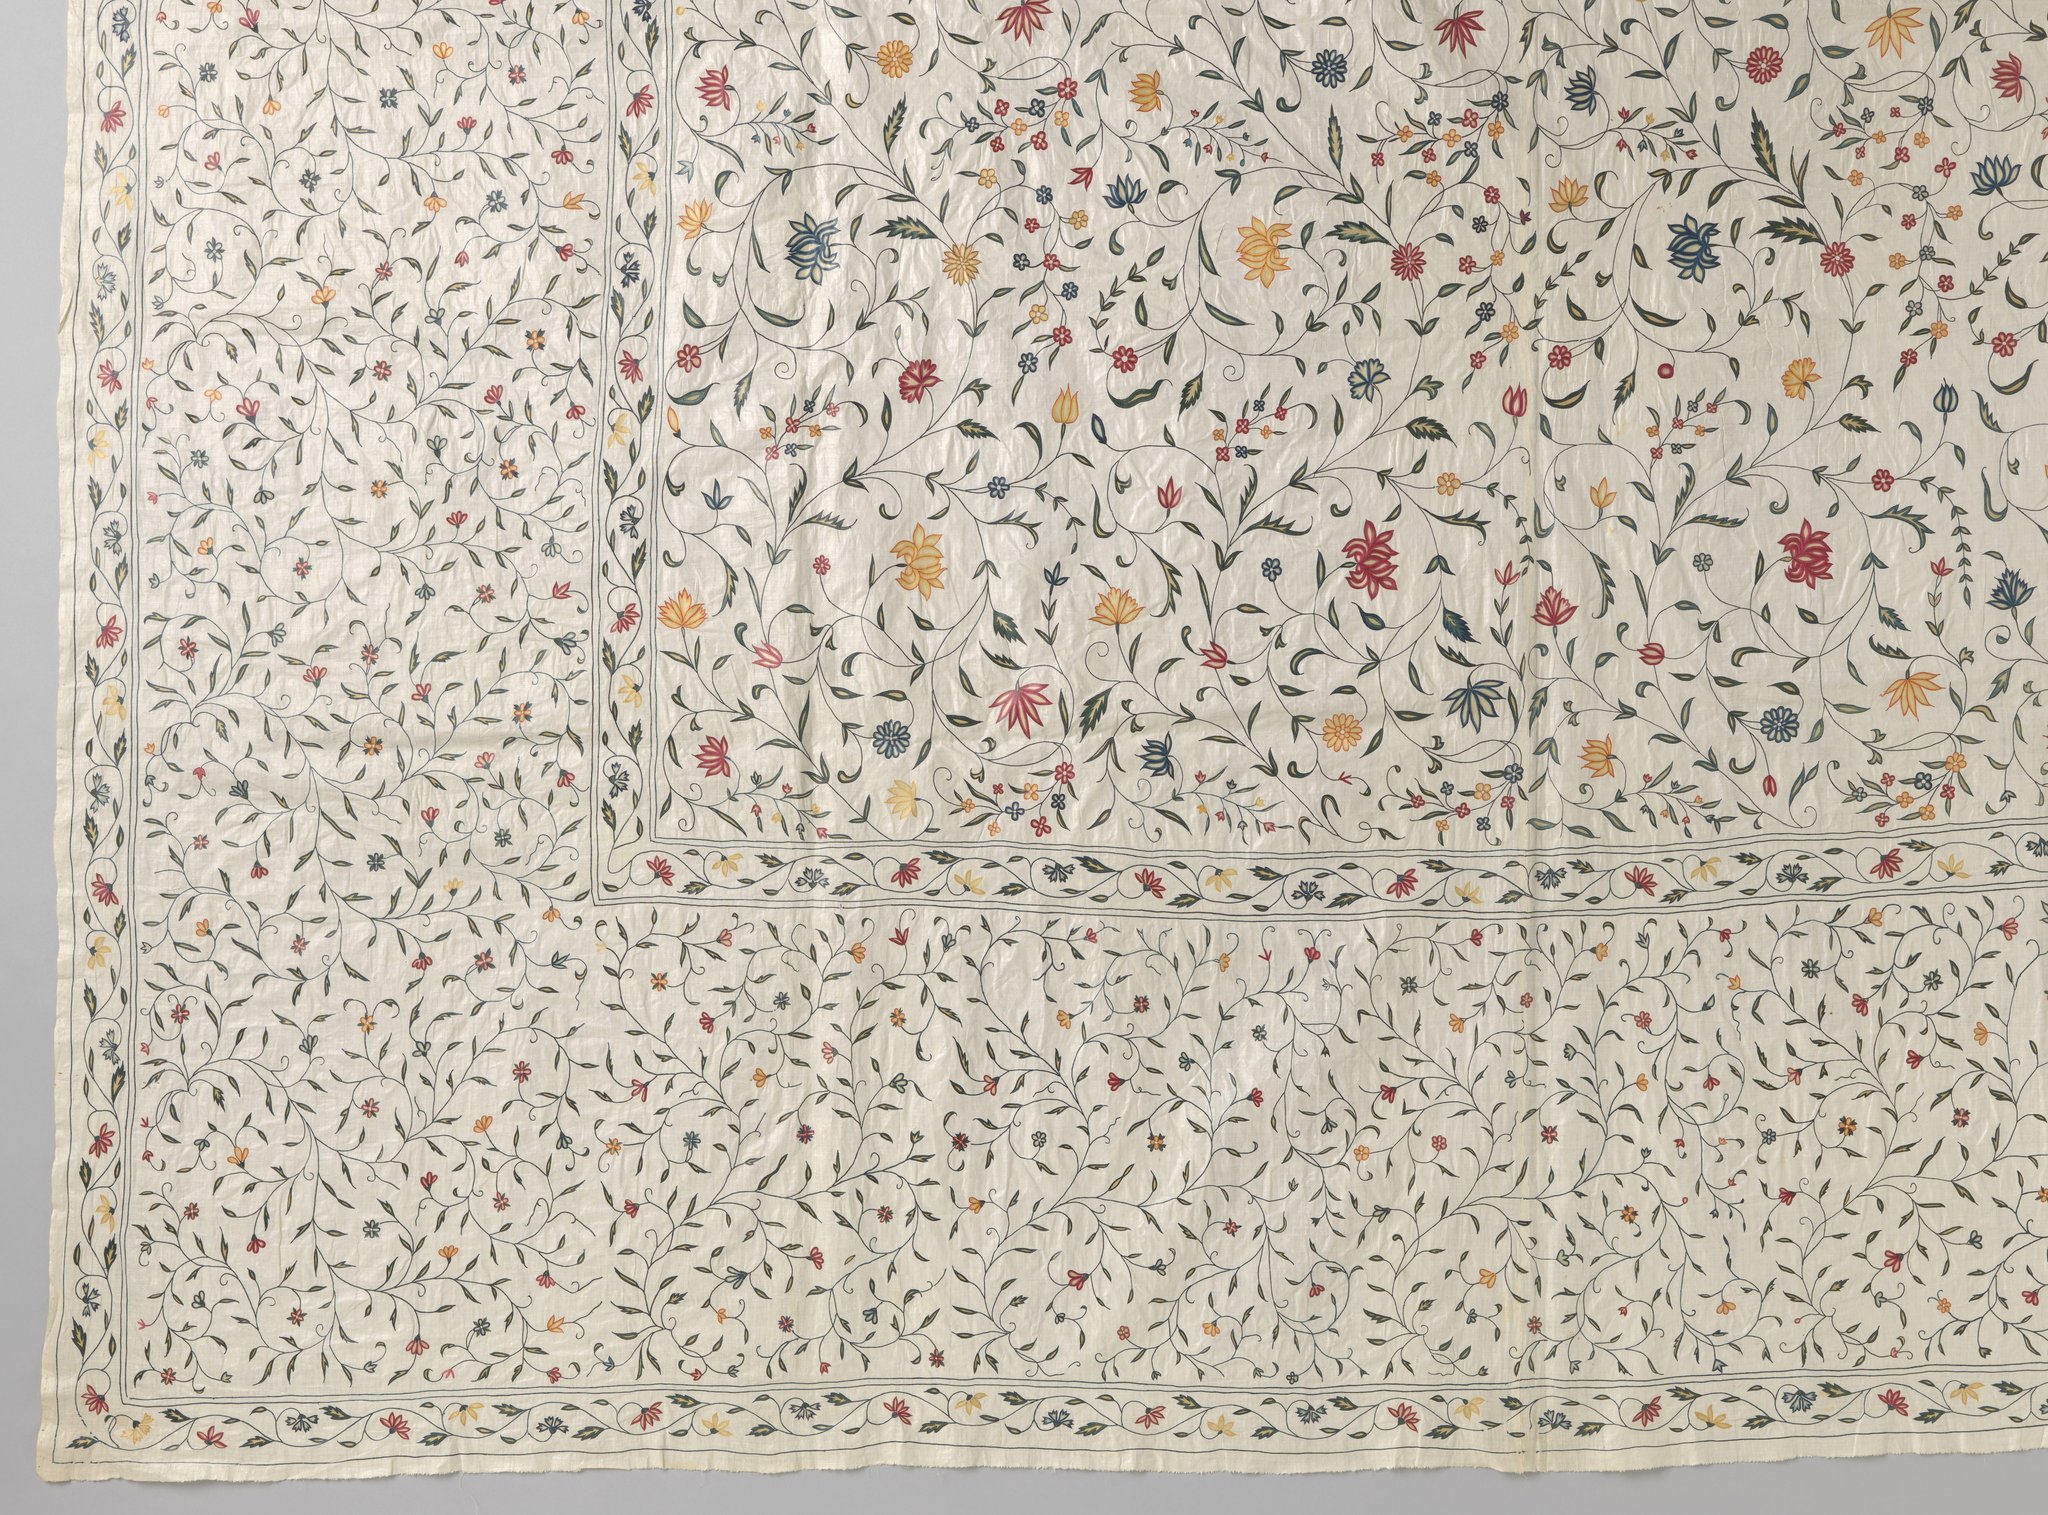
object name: textile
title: Sprei, veelkleurig getamboereerd, daarna geglansd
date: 1730-1750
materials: cotton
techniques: tambouring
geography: gujarat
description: Katoenen veelkleurige getamboereerde, daarna geglansde beddesprei, versierd met bloemtakken rondom een centraal ornament, oosters textiel.